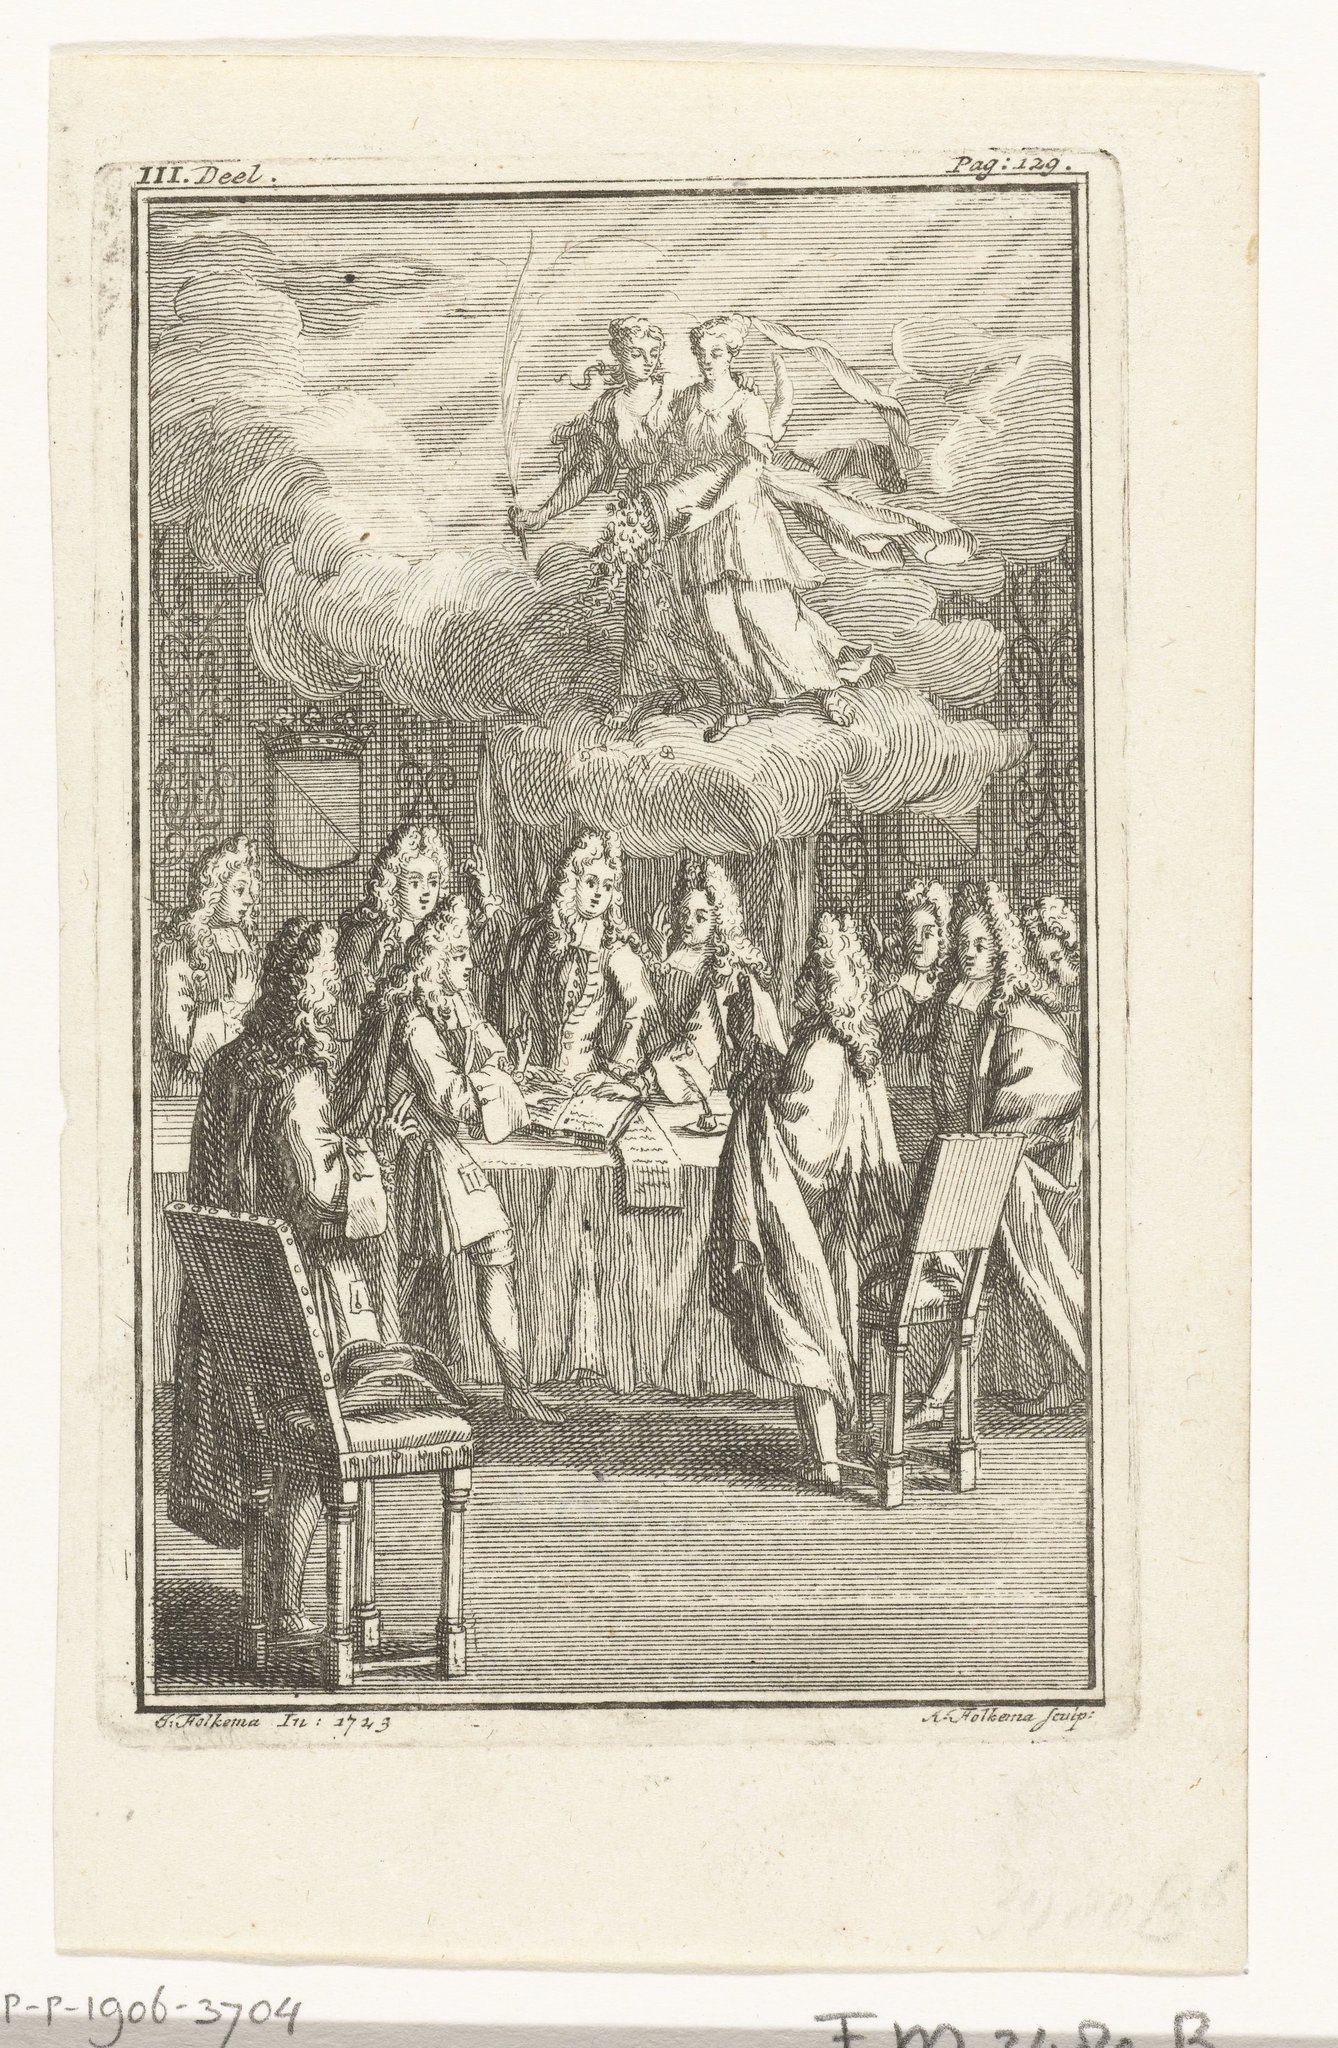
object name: print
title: Vrede van Utrecht, 1713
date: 1723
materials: paper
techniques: engraving, etching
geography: northern netherlands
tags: peace and prosperity, 'pax et abundantia', signing of peace treaty, concluding the peace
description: Allegorische voorstelling met de ondertekening van de Vrede van Utrecht in 1713, in de lucht de Vrede en de Overvloed. Gemerkt linksboven: III. Deel en rechtsboven: Pag: 129.